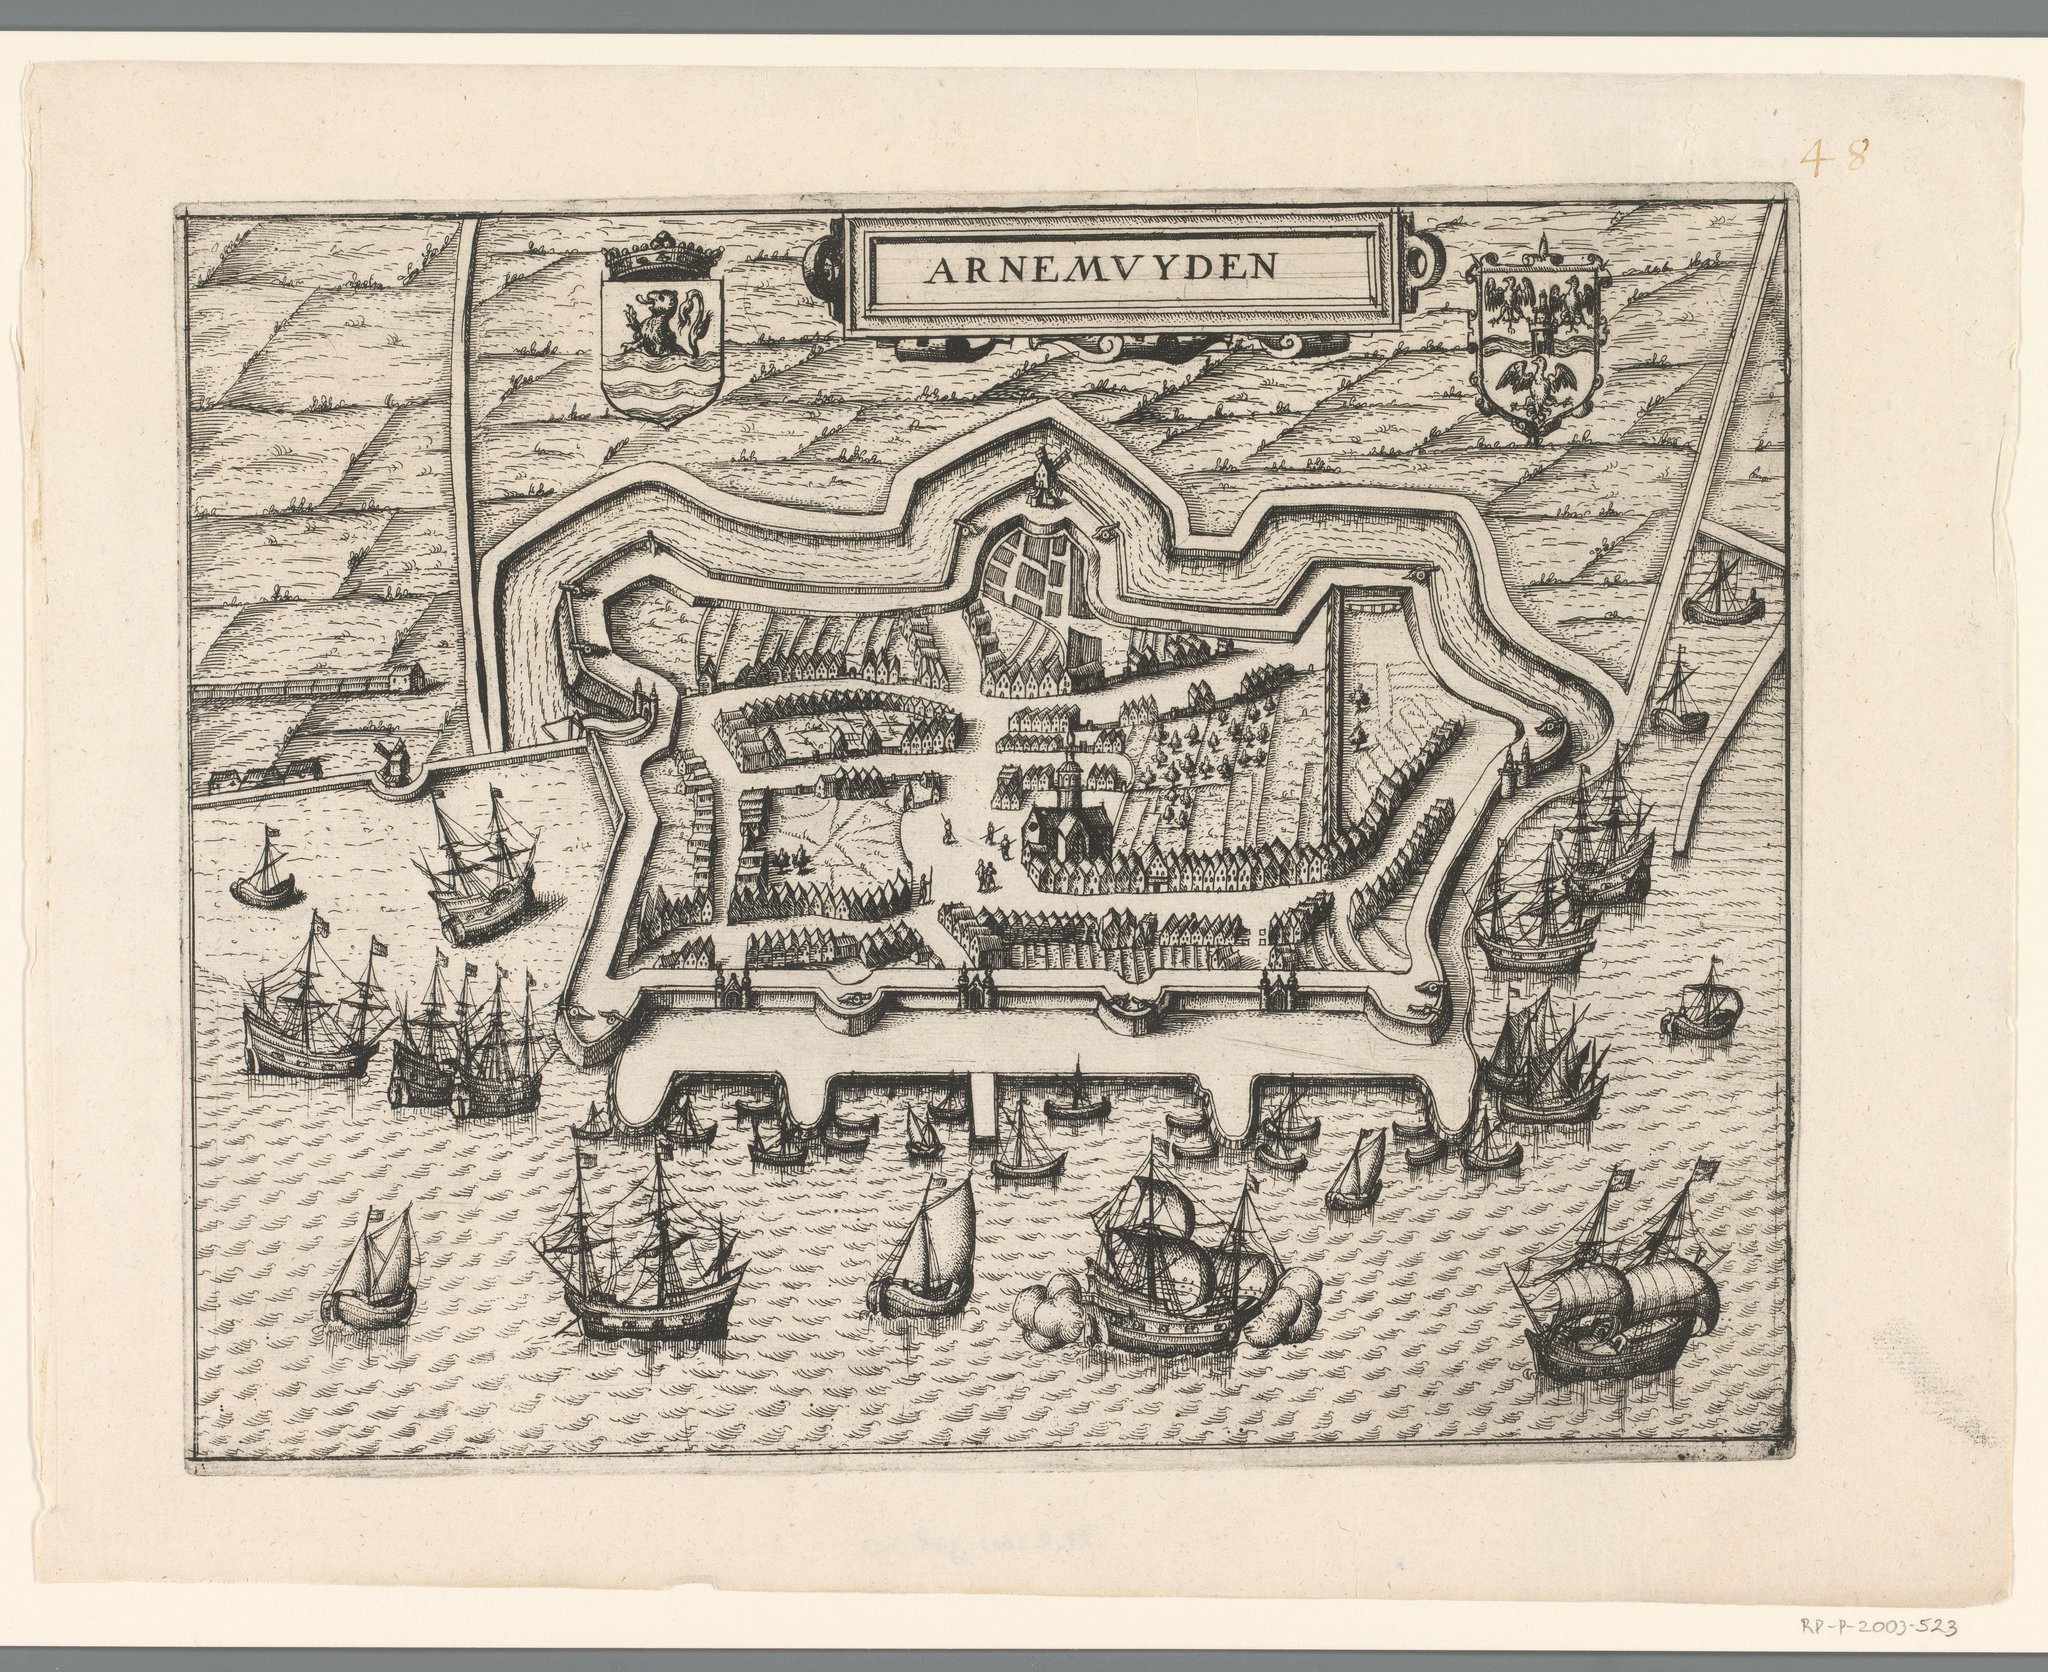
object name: print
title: Plattegrond van Arnemuiden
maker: Anonymous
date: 1607-1609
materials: paper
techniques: etching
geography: northern netherlands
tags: maps of cities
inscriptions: number: ‘48’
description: Plattegrond van de stad Arnemuiden. Midden boven een cartouche met de titel. Links daarvan het provinciewapen van Zeeland, rechts het stadswapen. Voor de haven enkele schepen waarvan één saluutschoten lost. Onderdeel van de verzameling kaarten genomen uit een latere editie van: Descrittione di tutti i Paesi Bassi van Lodovico Guicciardini.